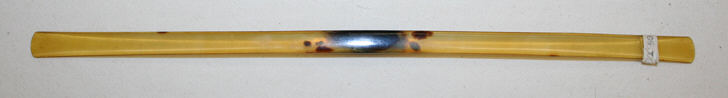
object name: stick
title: Stick of tortoiseshell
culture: japanese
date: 1700-1950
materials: shell